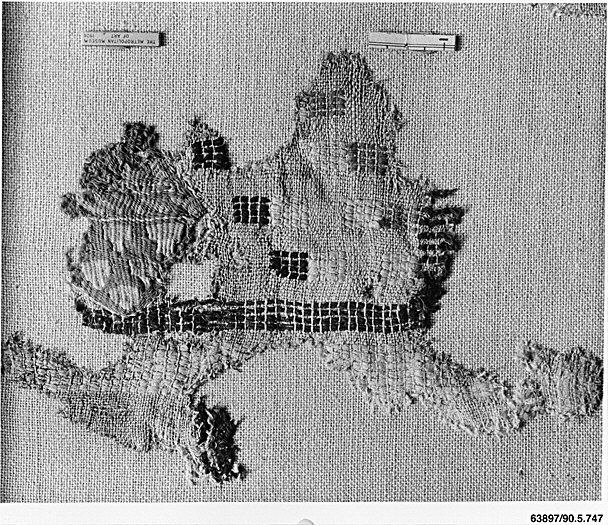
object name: textile fragment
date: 401-500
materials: linen, wool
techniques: brocade, weave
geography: egypt